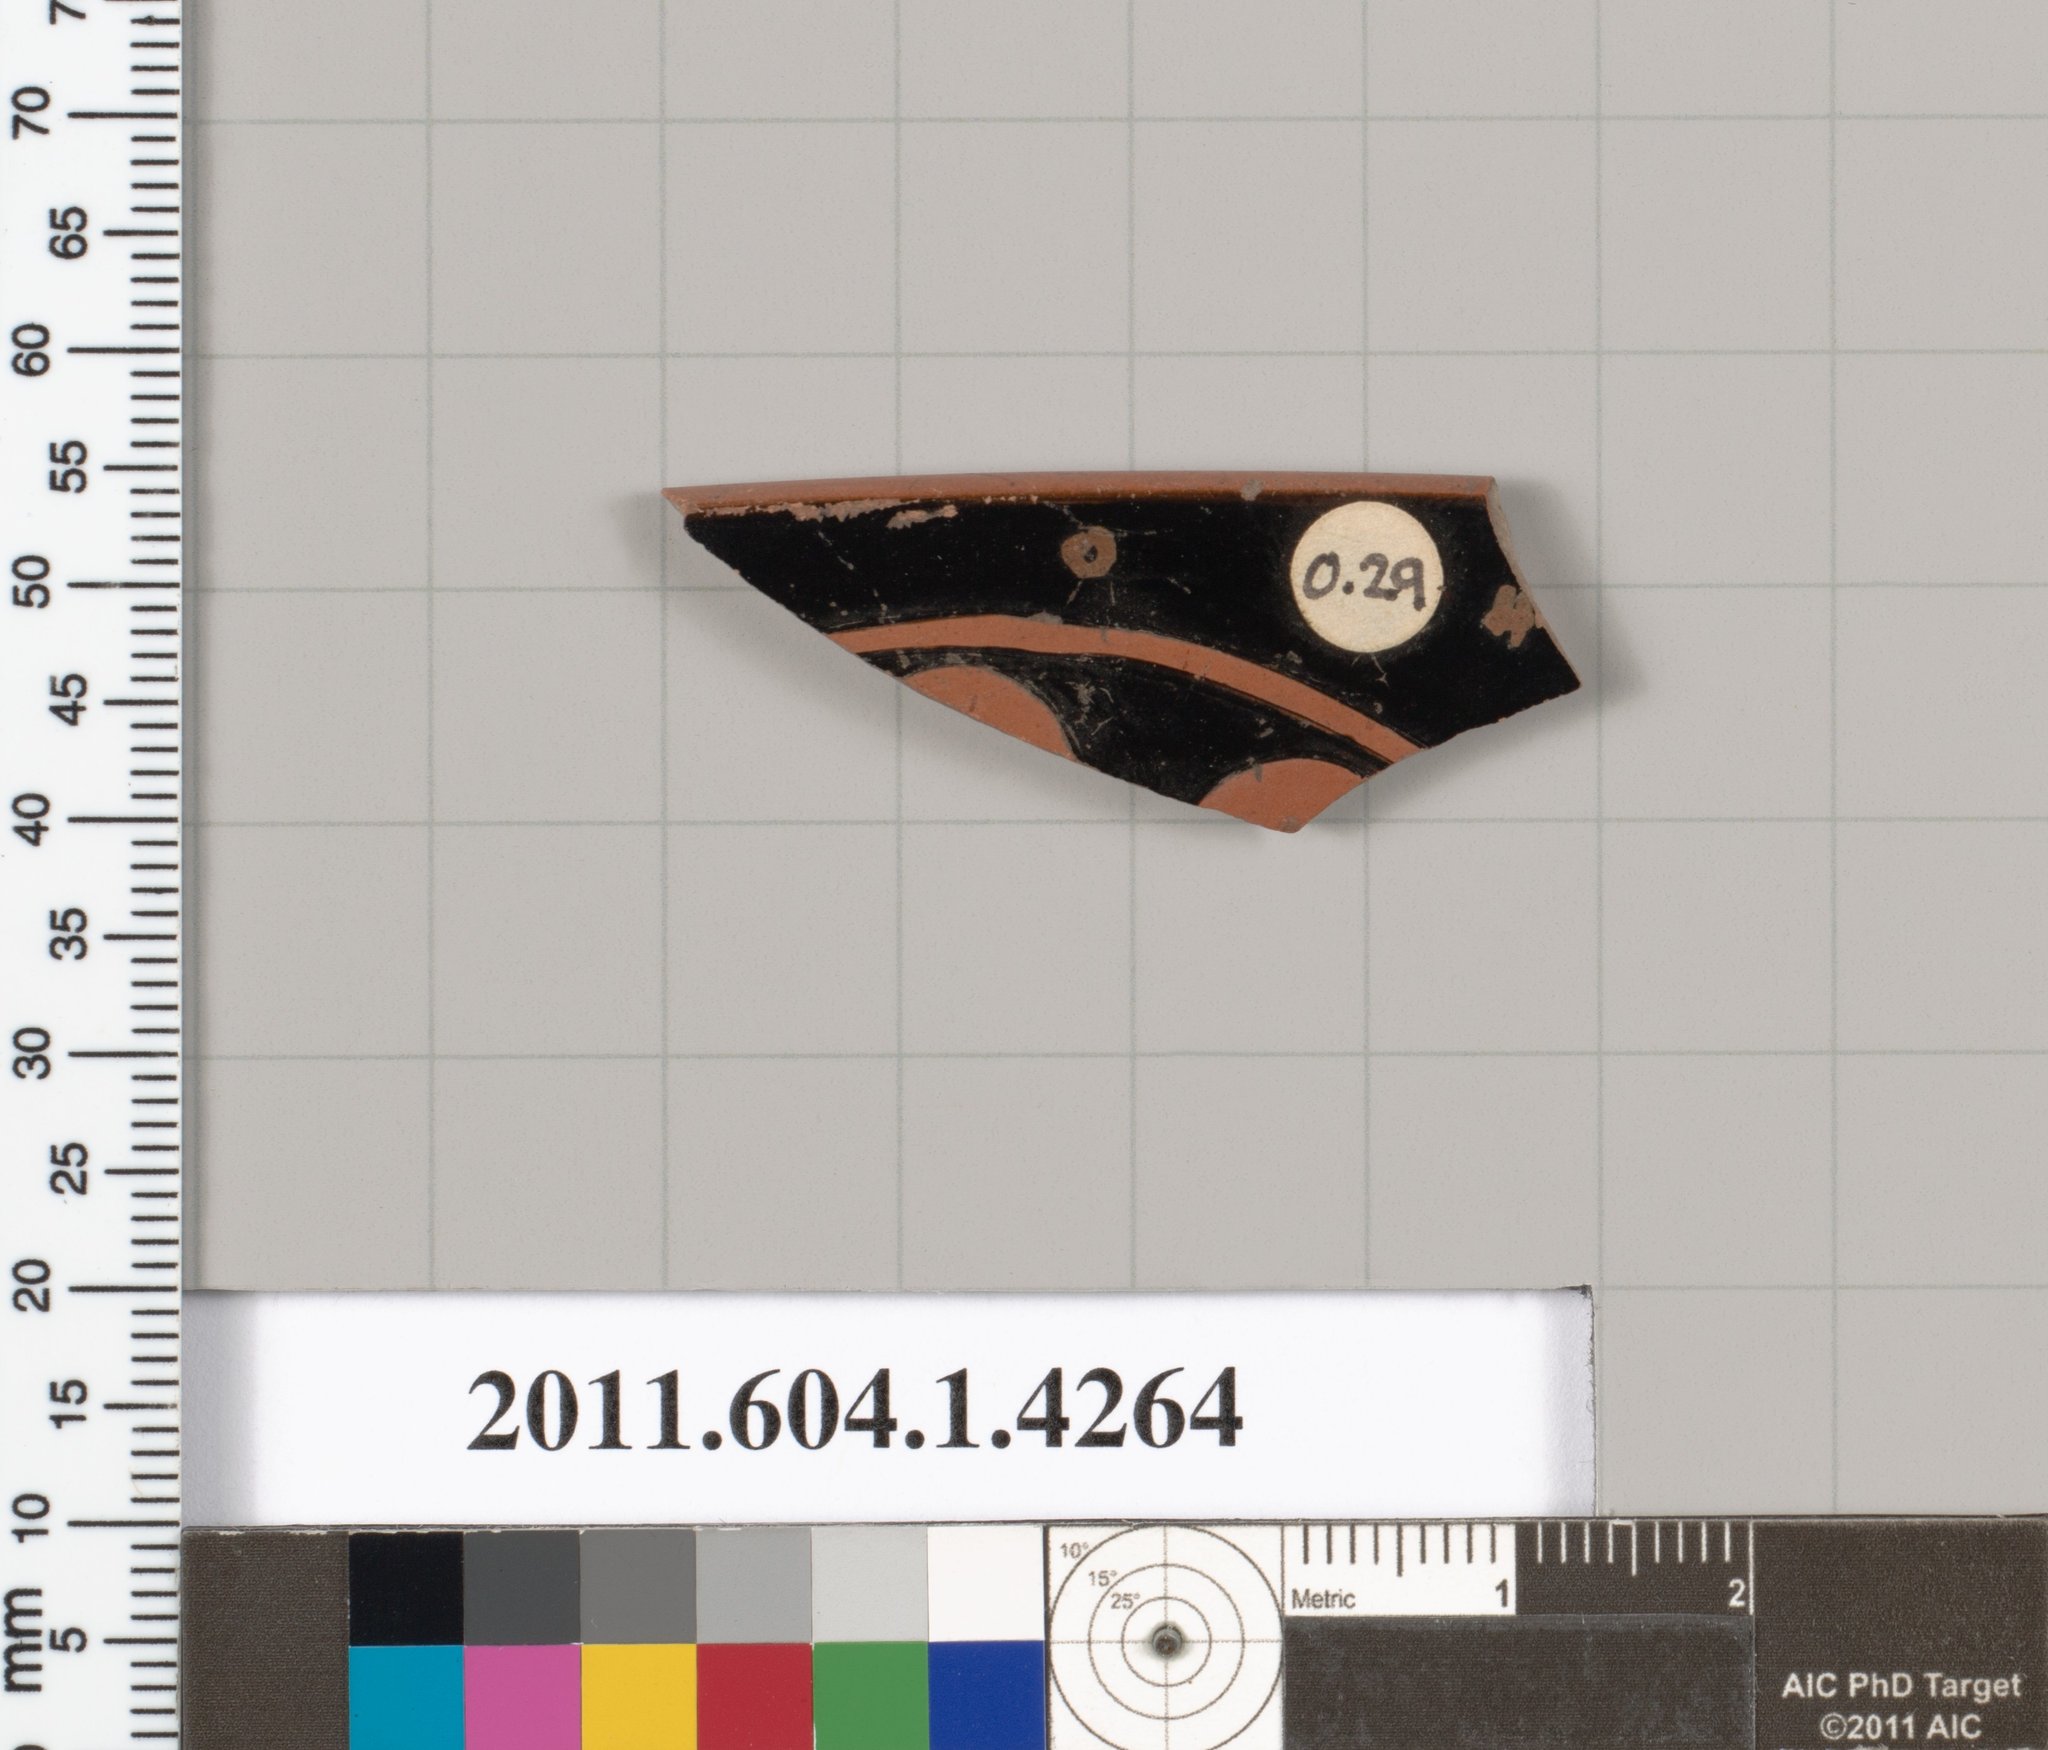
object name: kylix fragment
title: Terracotta rim fragment of a kylix (drinking cup)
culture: greek, attic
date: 520-500 BCE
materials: terracotta